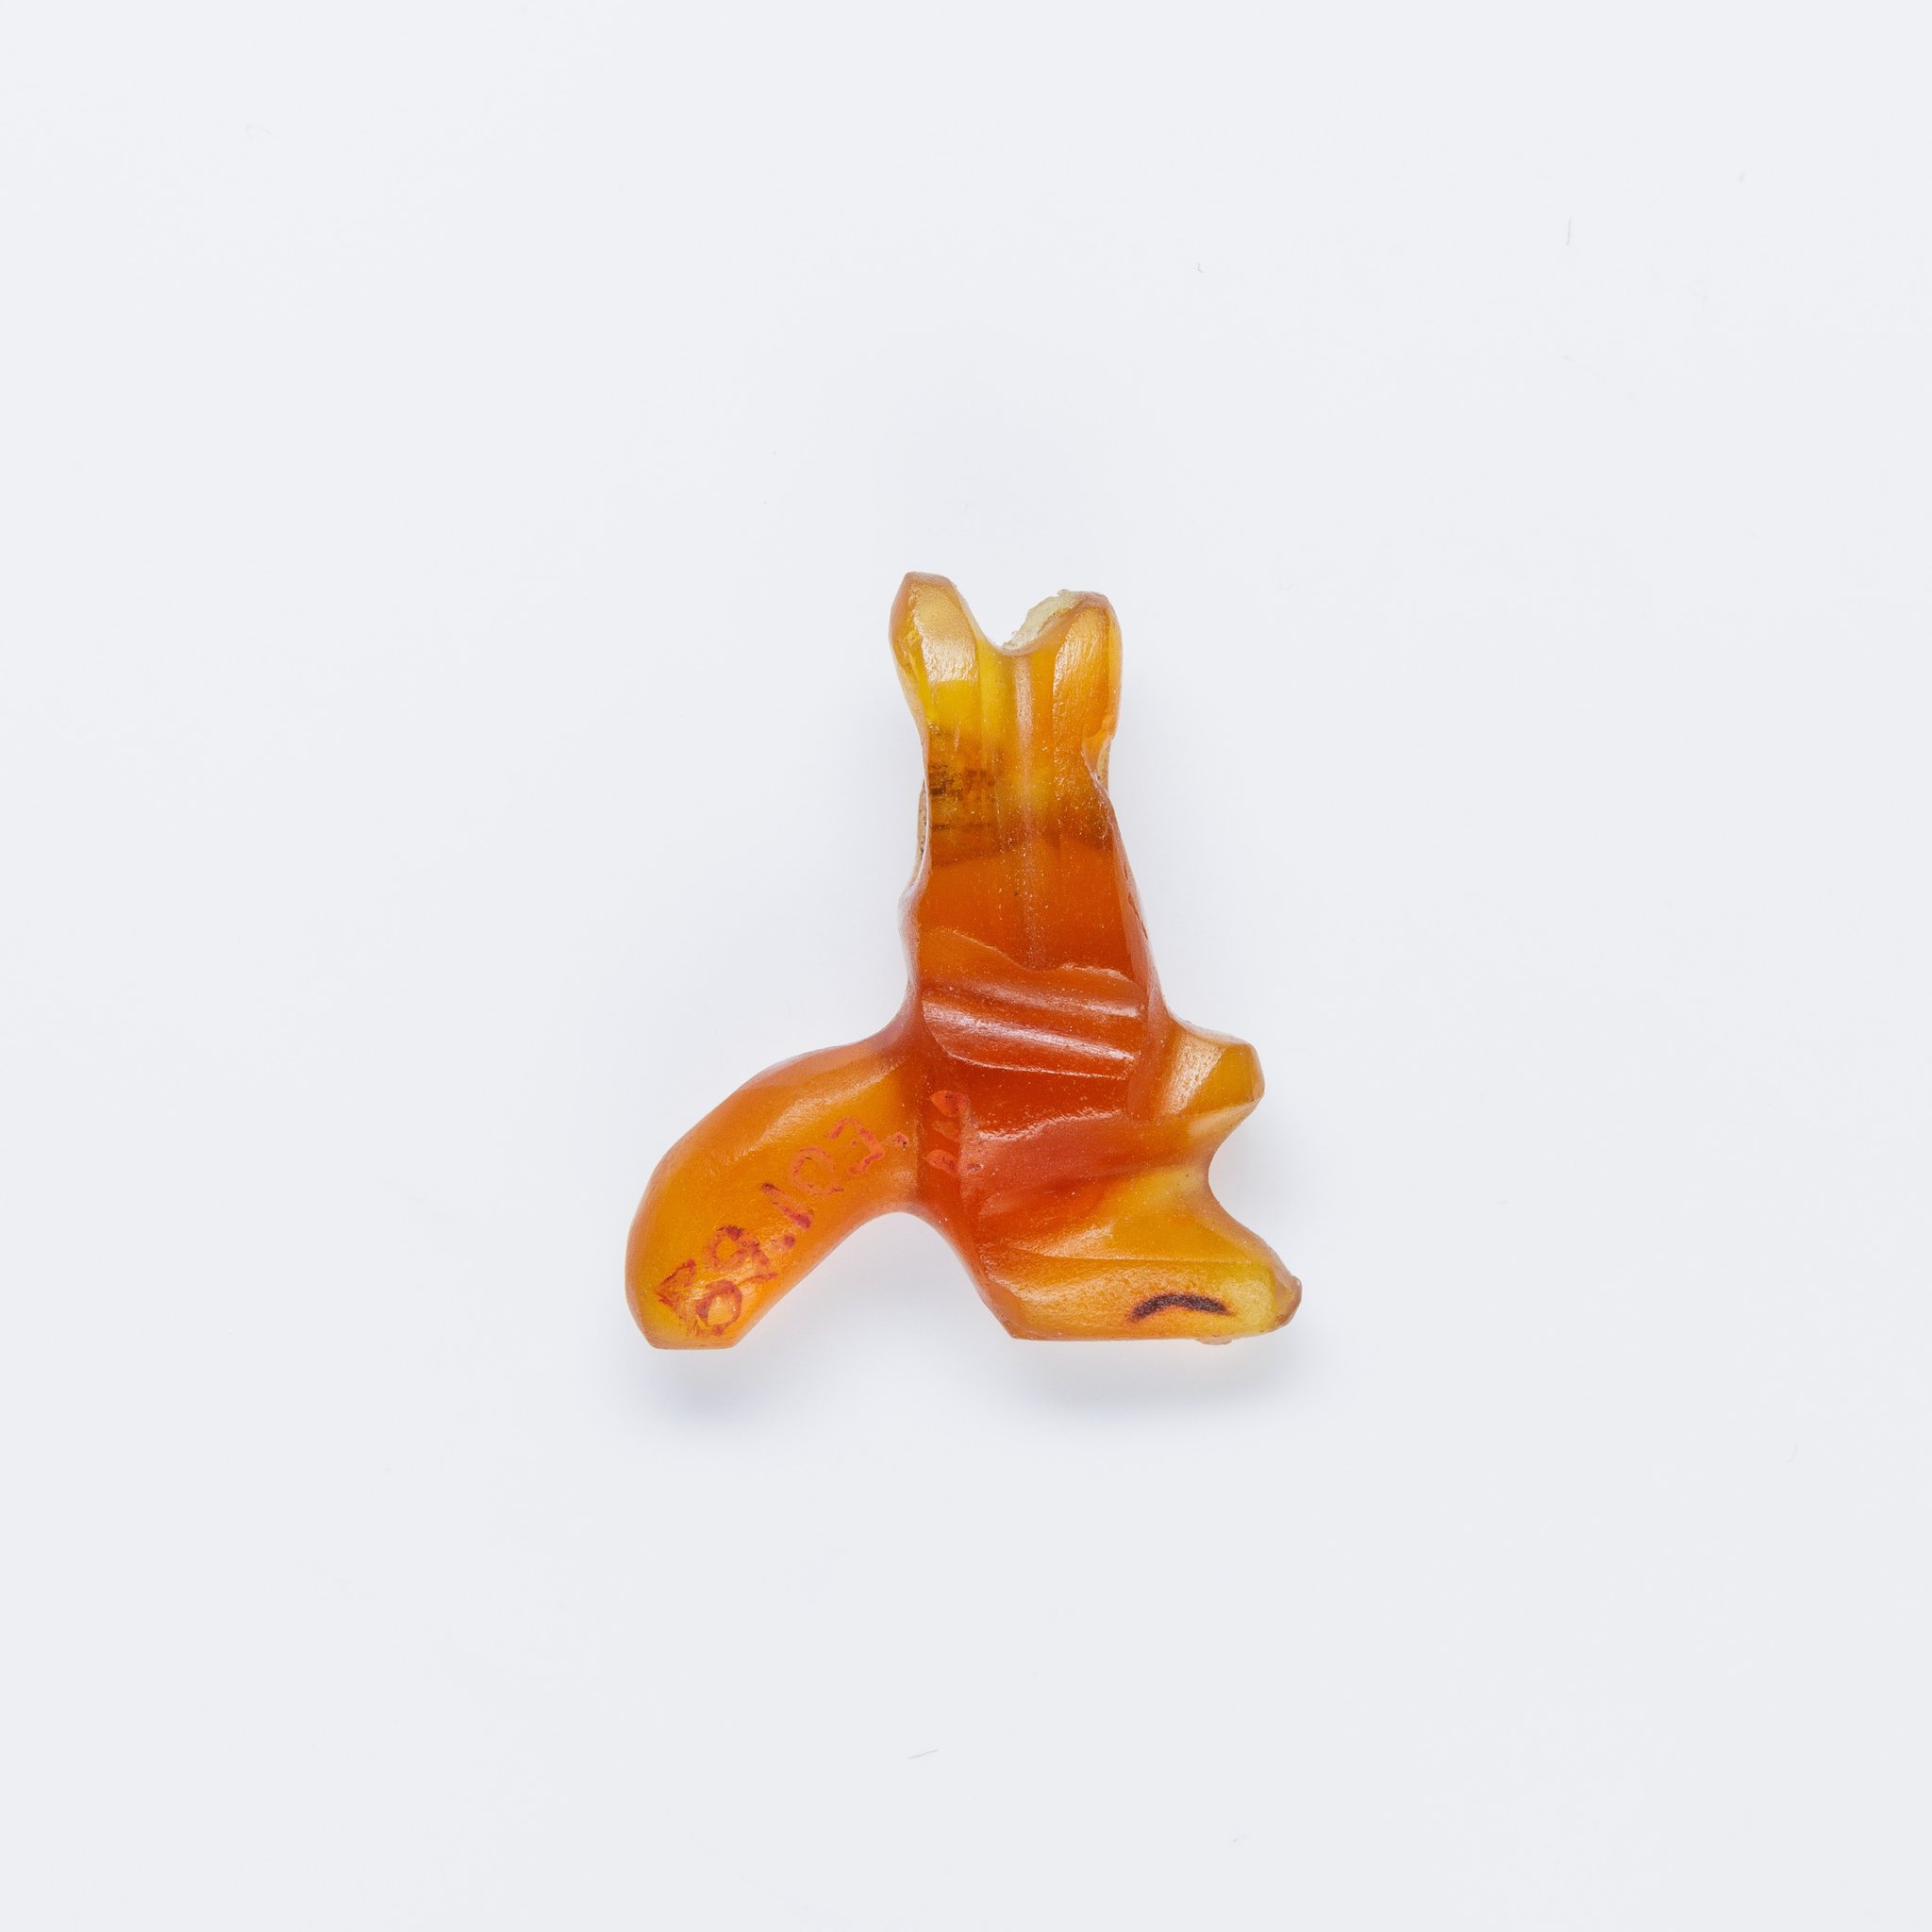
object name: amulet, bee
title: Bee amulet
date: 2150-1950 BCE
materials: gemstone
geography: southern upper egypt